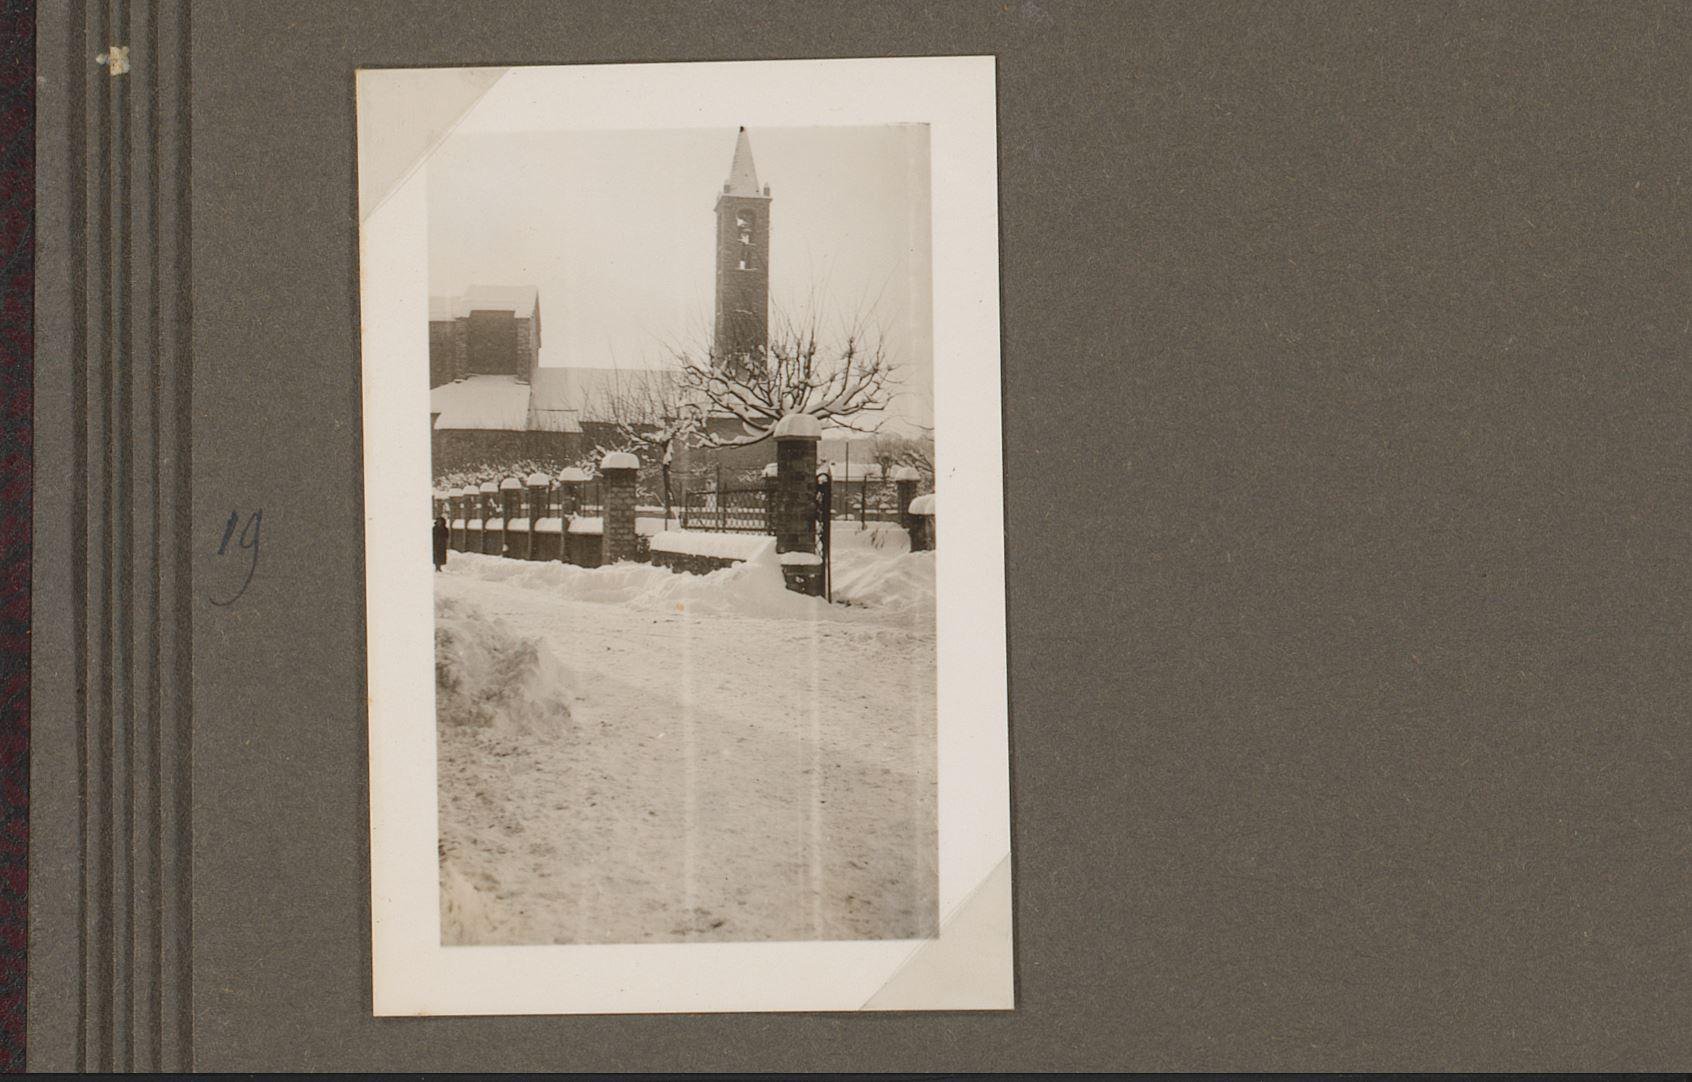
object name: photograph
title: Gezicht op de kerk van Tesserete, Zwitserland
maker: Anonymous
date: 1933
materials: photographic support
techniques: gelatin silver print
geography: tesserete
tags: church (exterior), snow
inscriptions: number: ‘19’